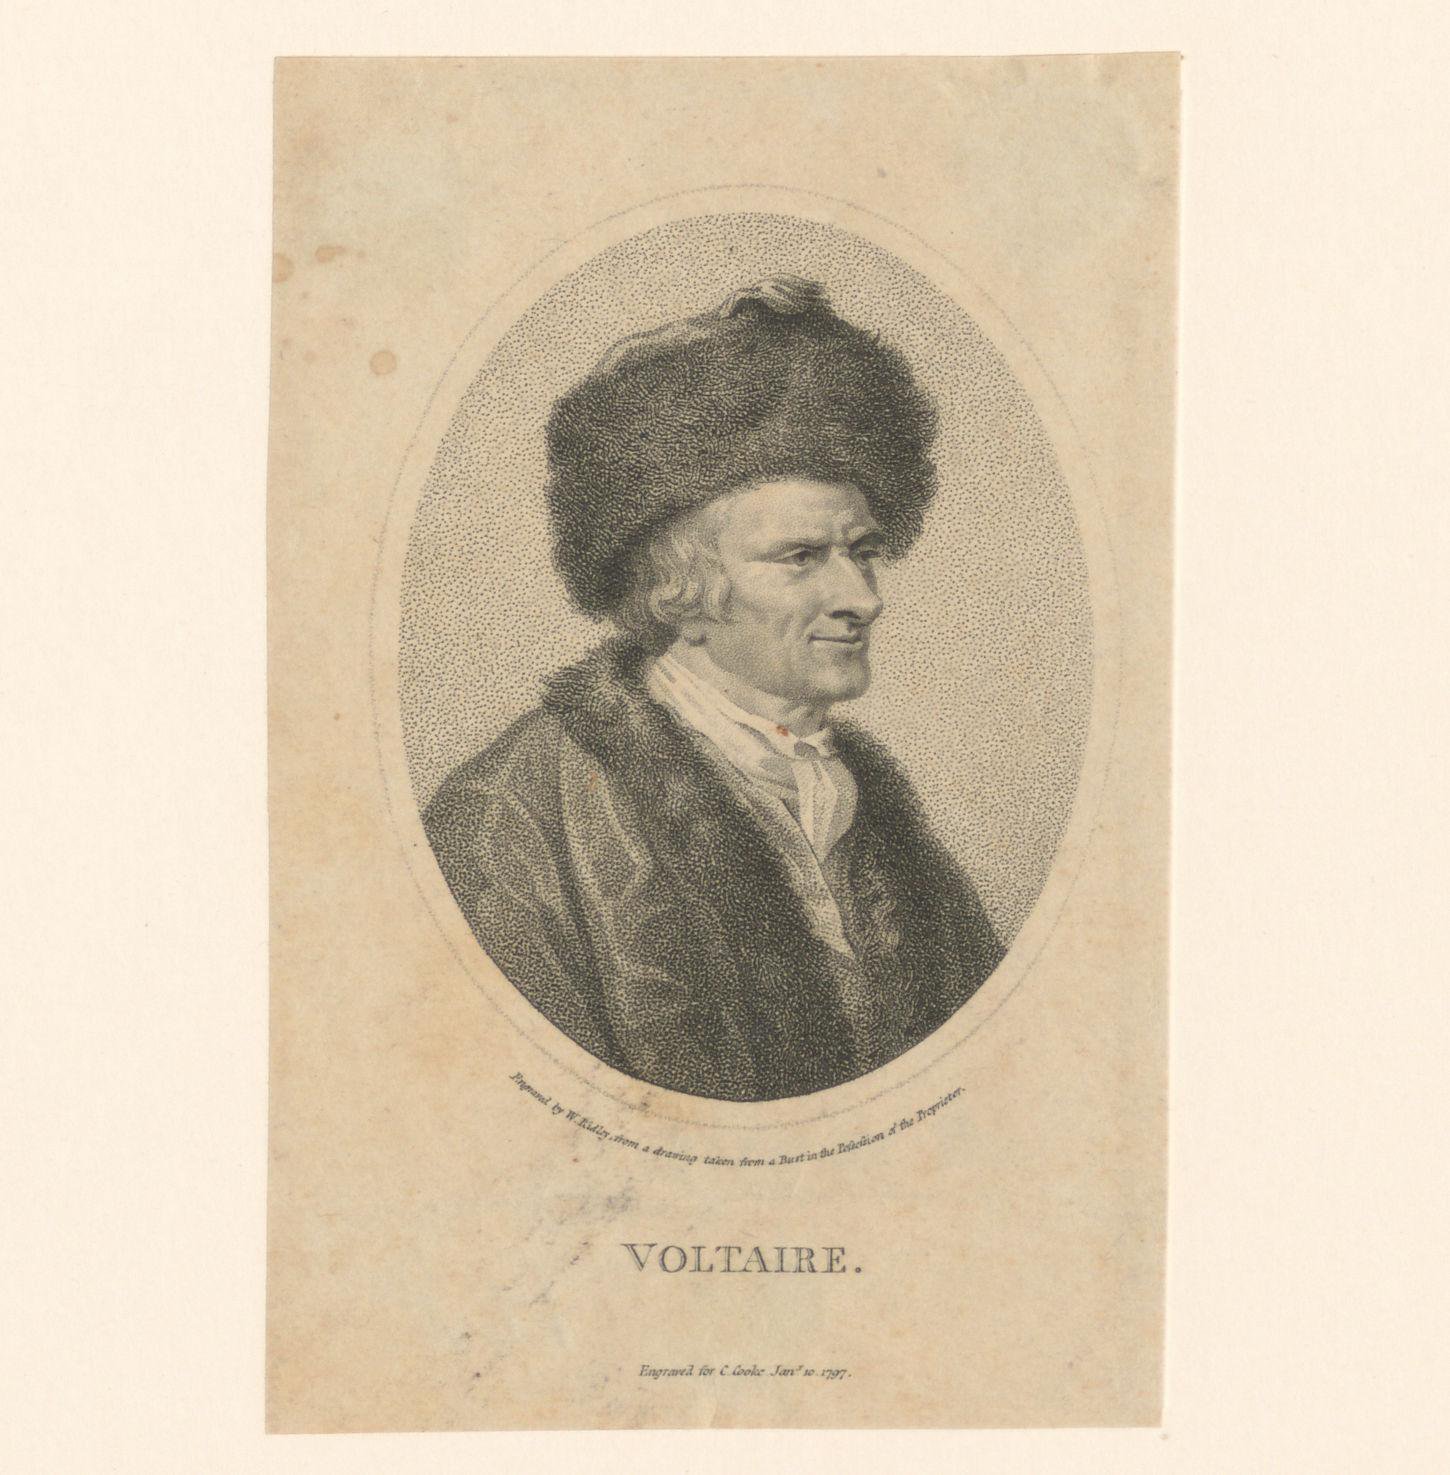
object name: print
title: Portret van Voltaire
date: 1797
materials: paper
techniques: stippling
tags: paris, voltaire, historical persons, scholar, philosopher (+ portrait of scholar, scientist)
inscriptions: collector's mark: Lugt 2228